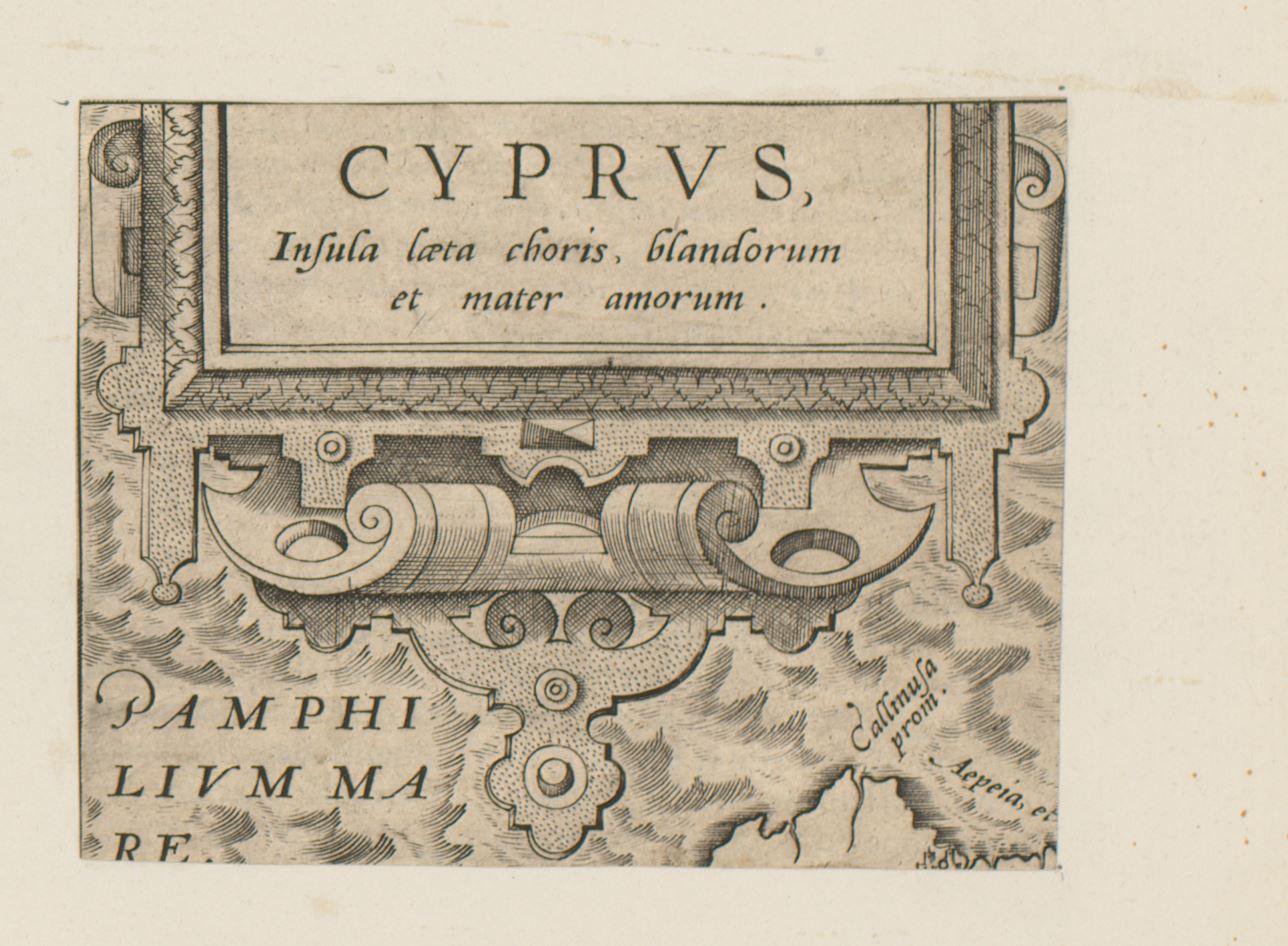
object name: print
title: Cartouche van een kaart van eilanden in de Middellandse Zee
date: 1584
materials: paper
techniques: engraving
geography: antwerp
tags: scrollwork, strapwork ~ ornament, ornament ~ cartouche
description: Rechthoekige cartouche met rolwerk. De cartouche is een fragment van een kaart van de eilanden in de Middellandse Zee, waaronder Cyprus. De prent maakt deel uit van een album.